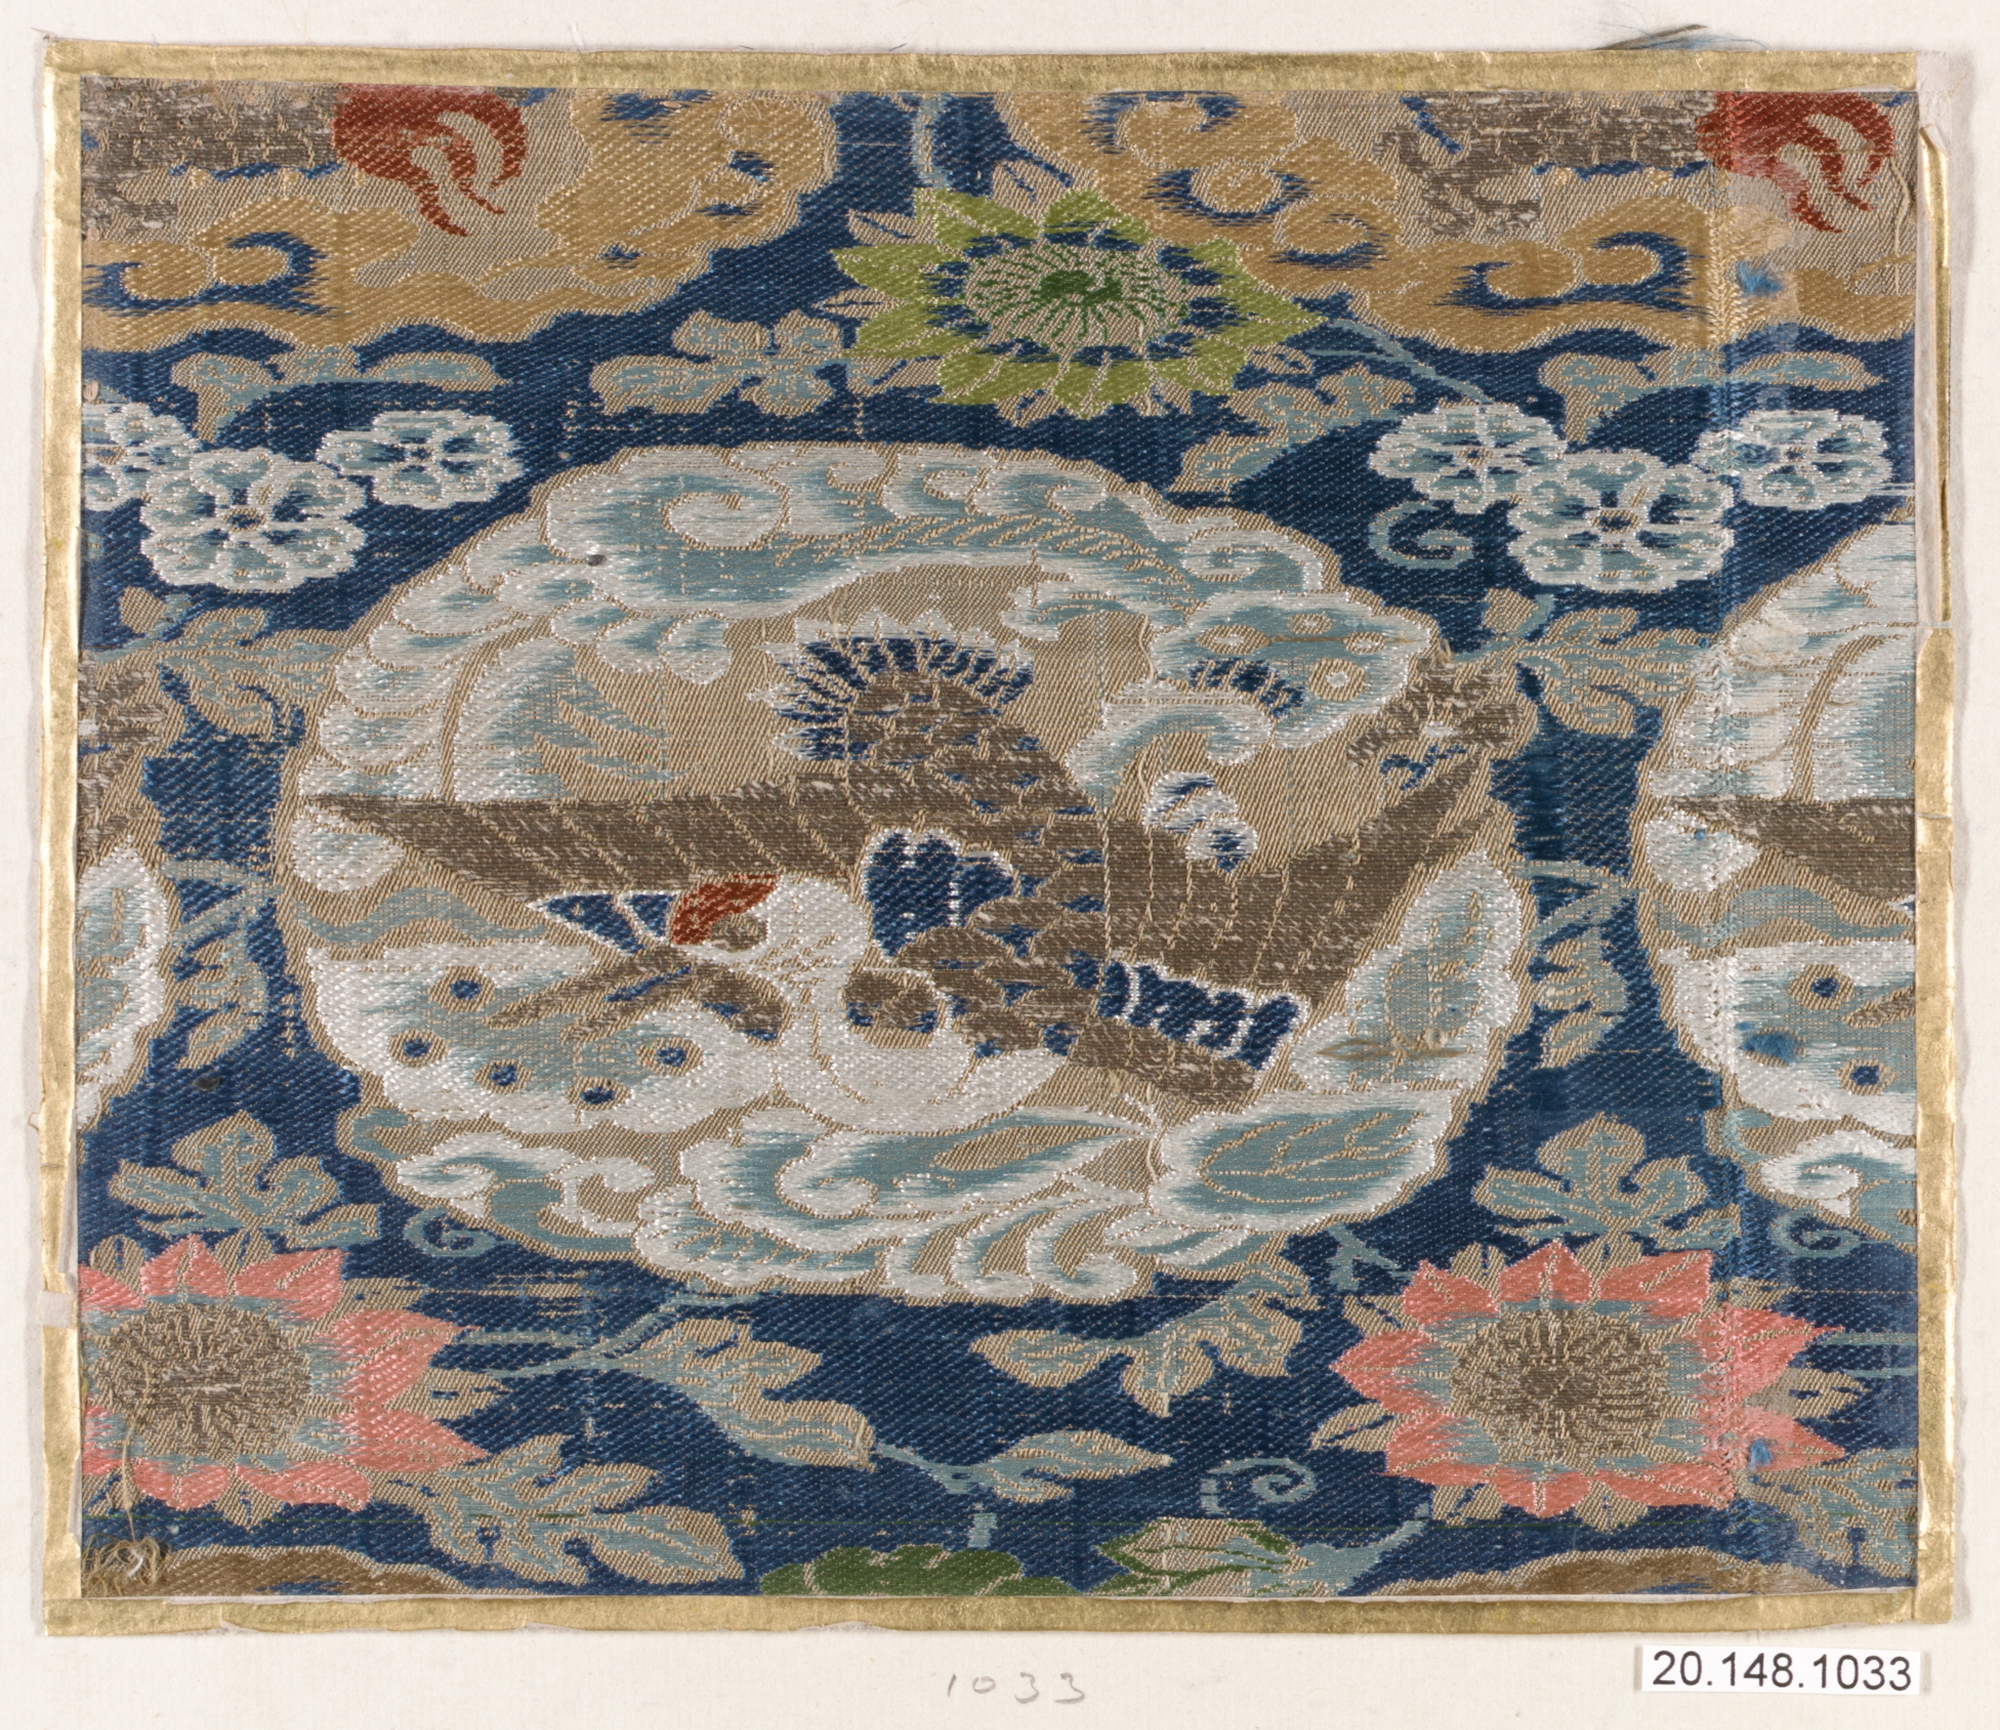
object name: piece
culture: japanese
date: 1701-1800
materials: silk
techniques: compound weave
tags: birds,flowers